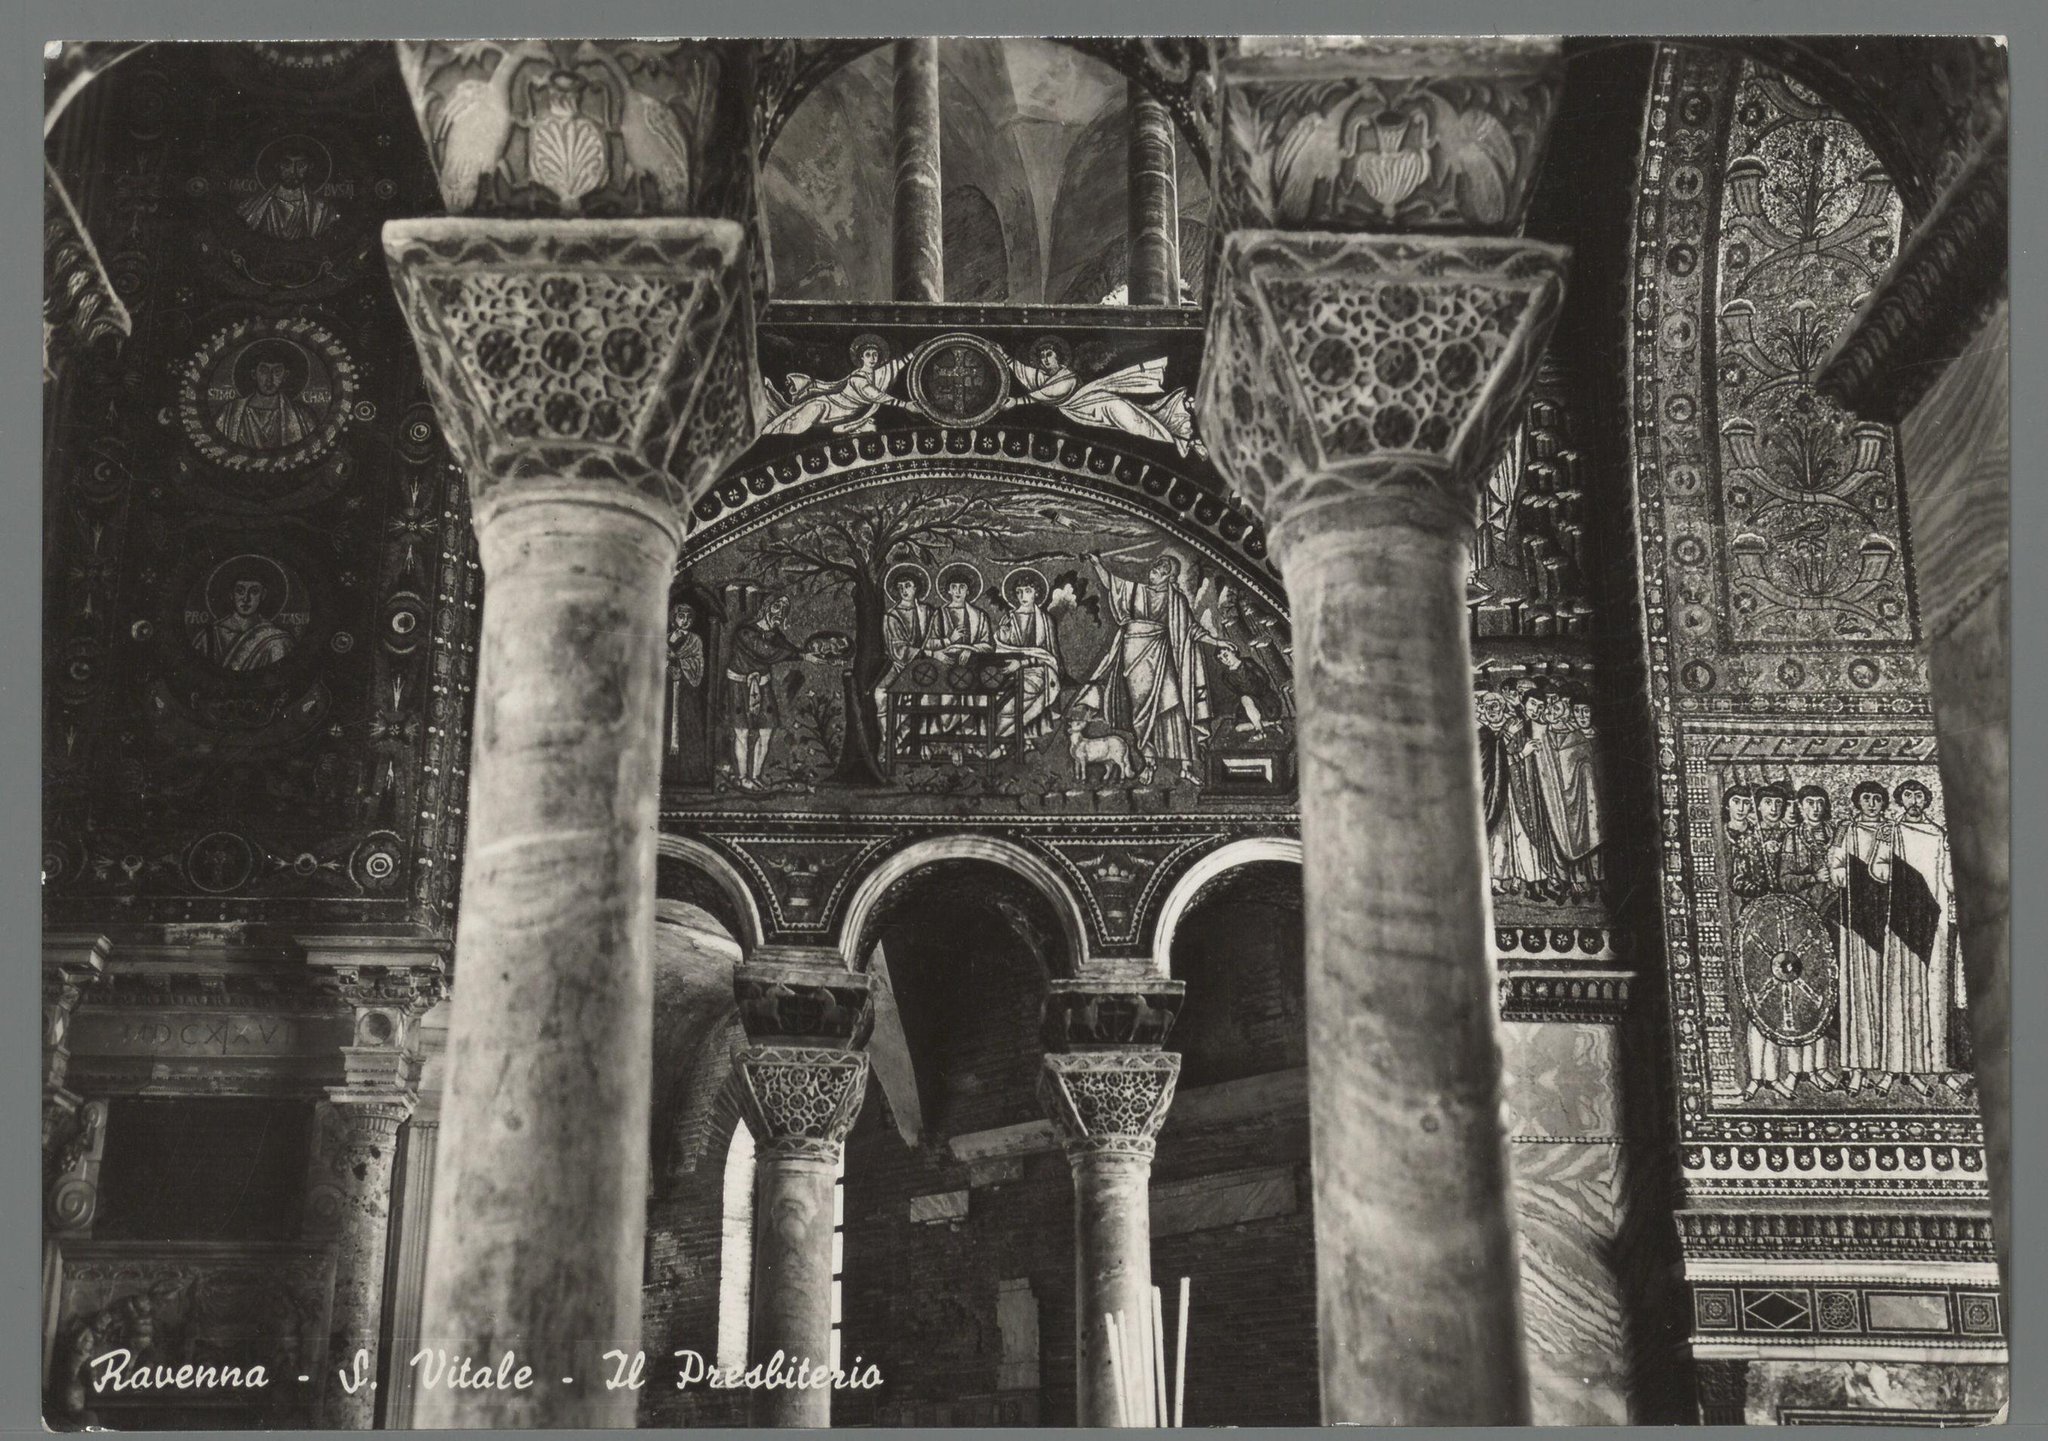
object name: photograph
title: Ravenna. S. Vitale. Il presbiterio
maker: Anonymous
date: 1940-1970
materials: photographic support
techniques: photography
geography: turin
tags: column, pillar ~ architecture, interior of church